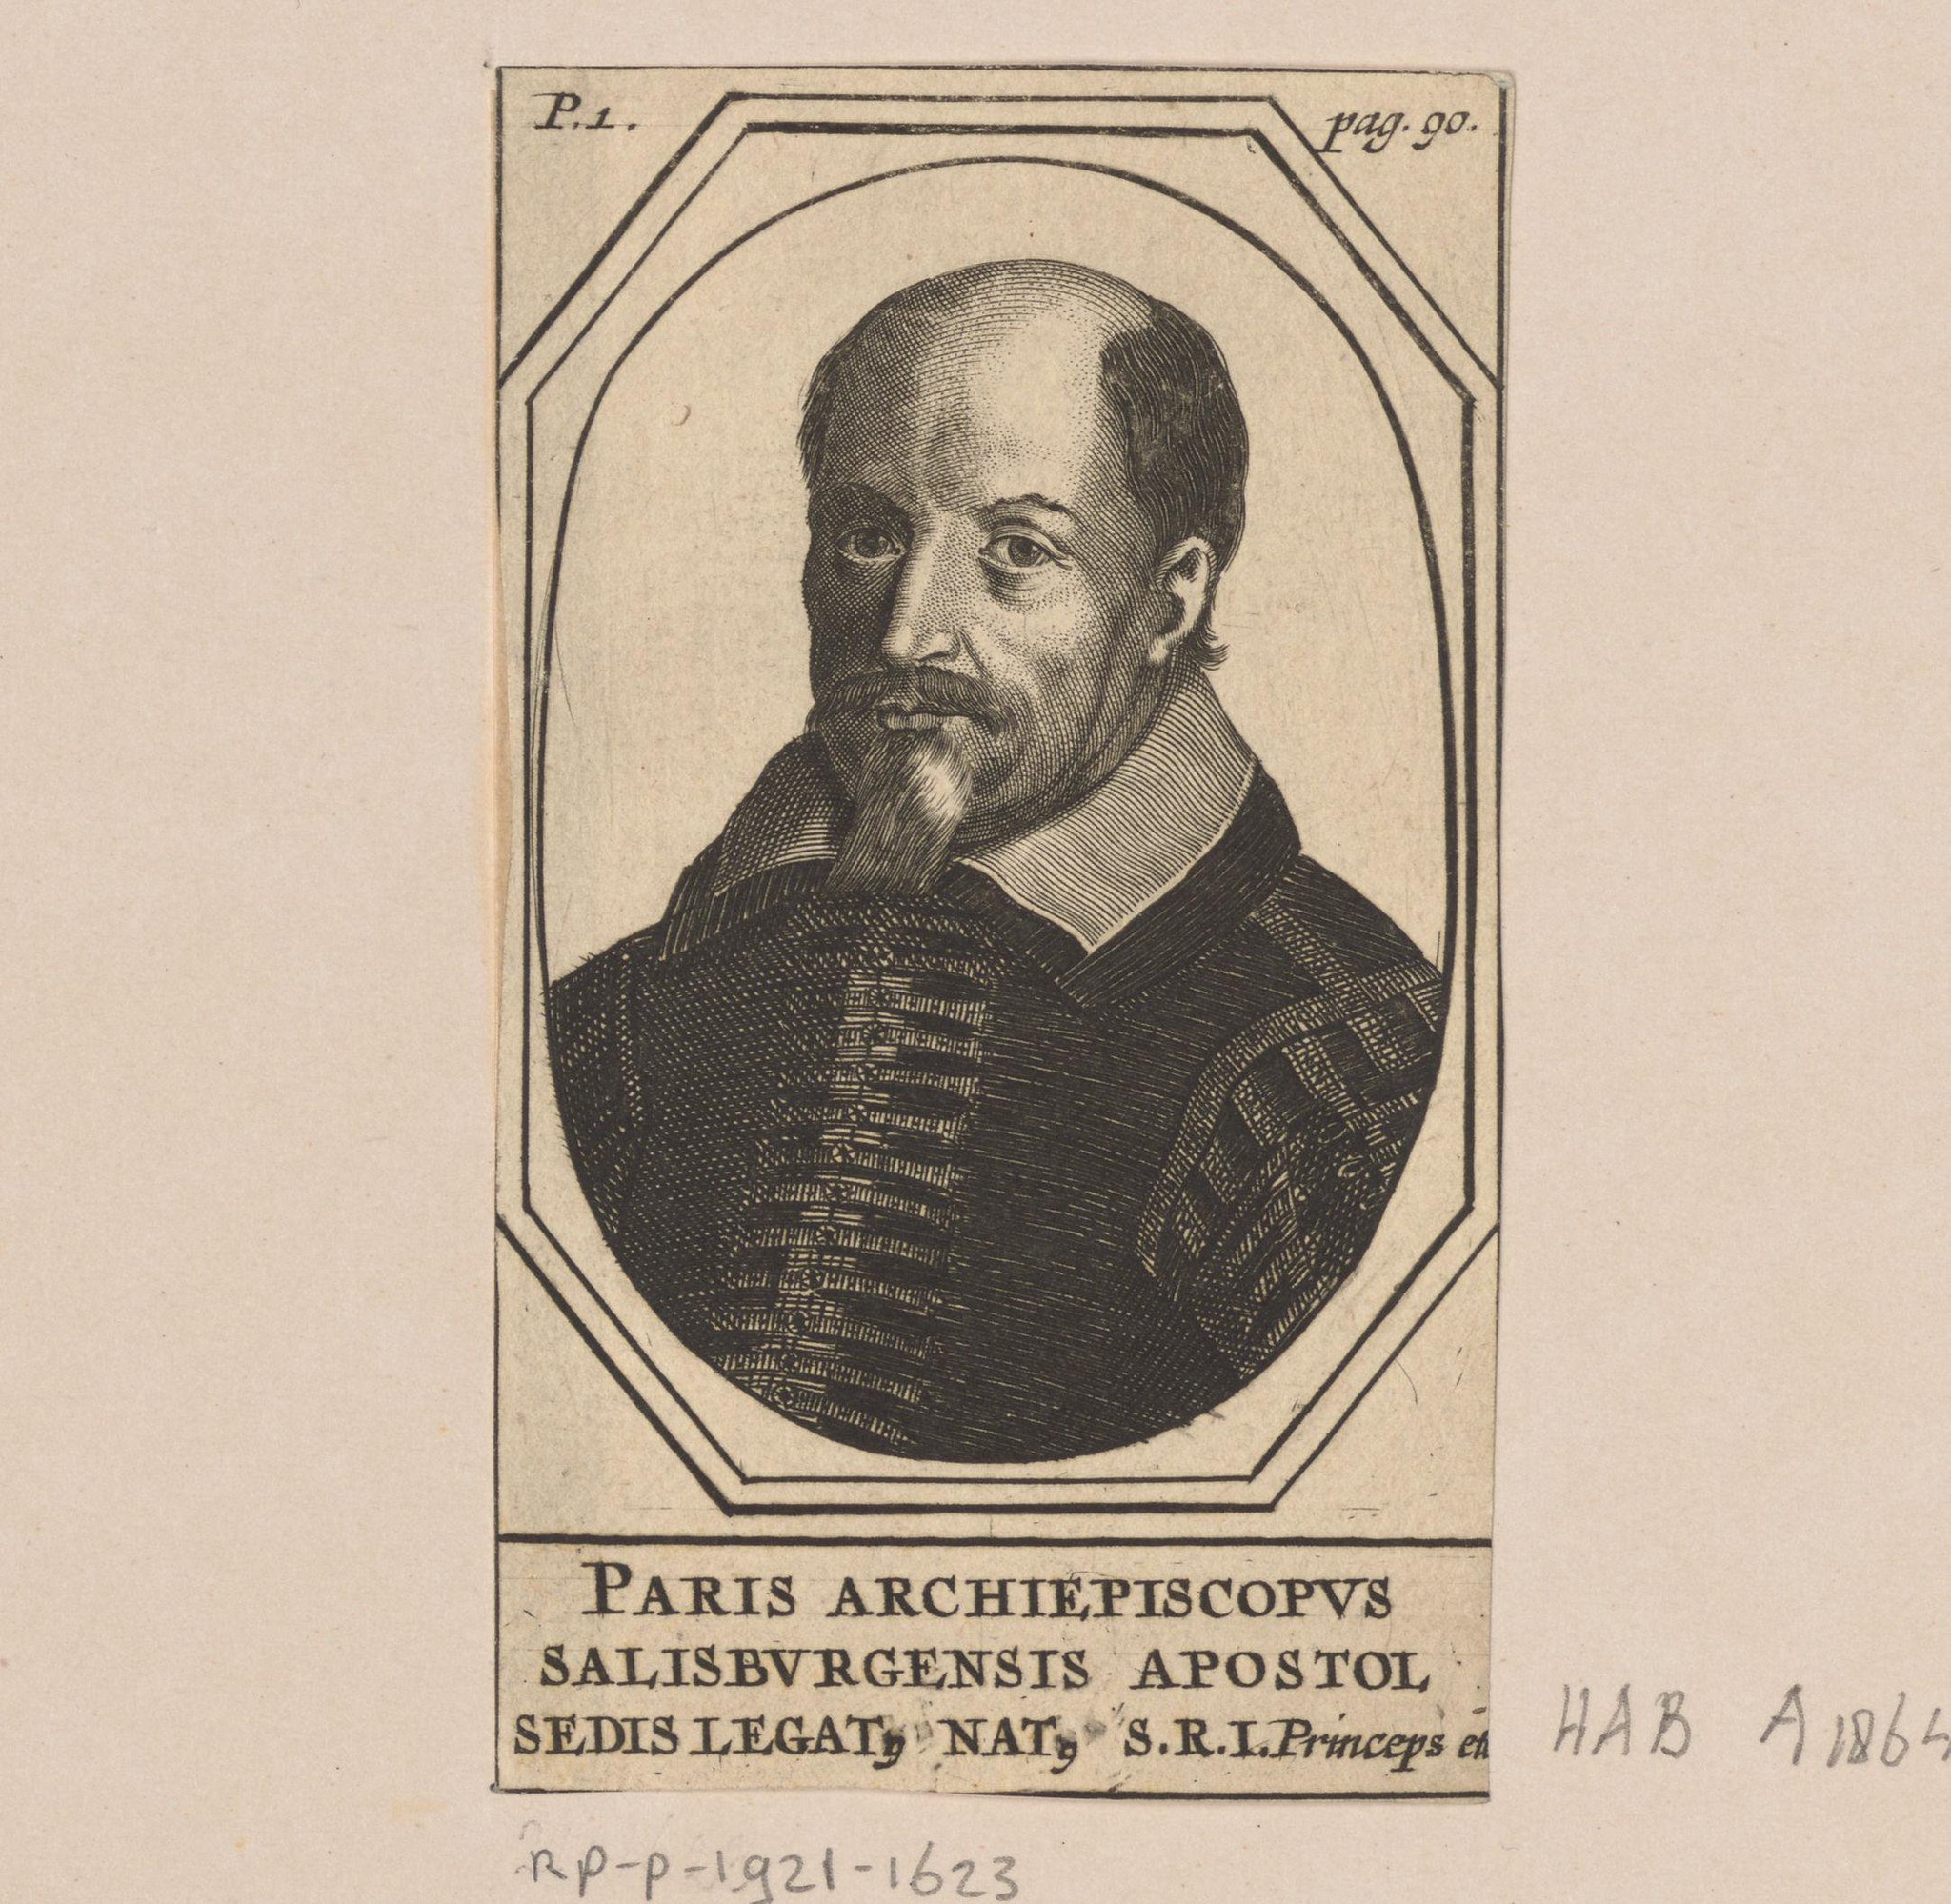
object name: book illustration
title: Portret van Paris von Lodron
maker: Anonymous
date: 1655-1659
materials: paper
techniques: engraving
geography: northern netherlands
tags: historical persons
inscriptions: collector's mark: Lugt 2233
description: Prent waarschijnlijk uit: Brachelius, Johannes Adolphus. Historiarum nostri temporis editio ultima (…). Amsterdam: Jacob van Meurs en Johannes Janssonius, 1655. Prent ook gebruikt in de tweede editie van 1659.